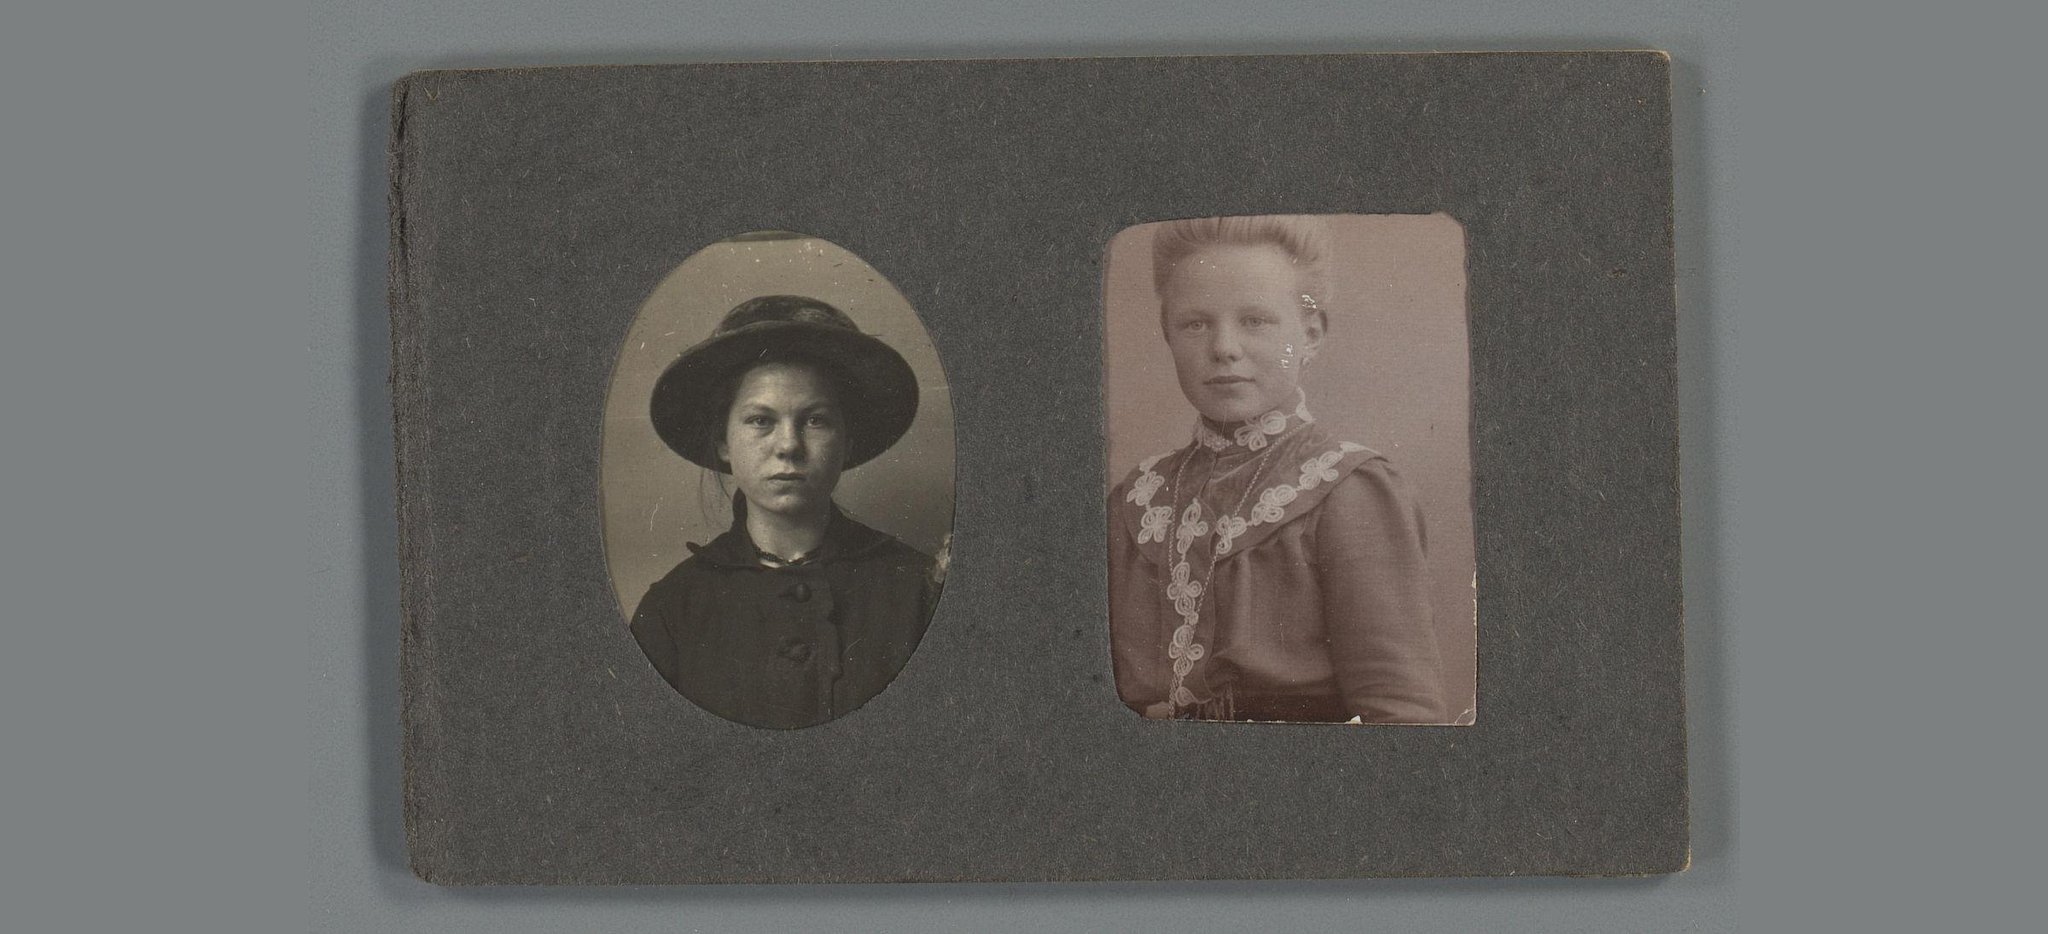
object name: photograph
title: Twee portretten van twee onbekende meisjes, een met hoed; gevat in een houder van karton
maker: Anonymous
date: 1890-1910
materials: paper, cardboard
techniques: gelatin silver print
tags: historical persons not known by name - bb - woman, girl (child between toddler and youth)